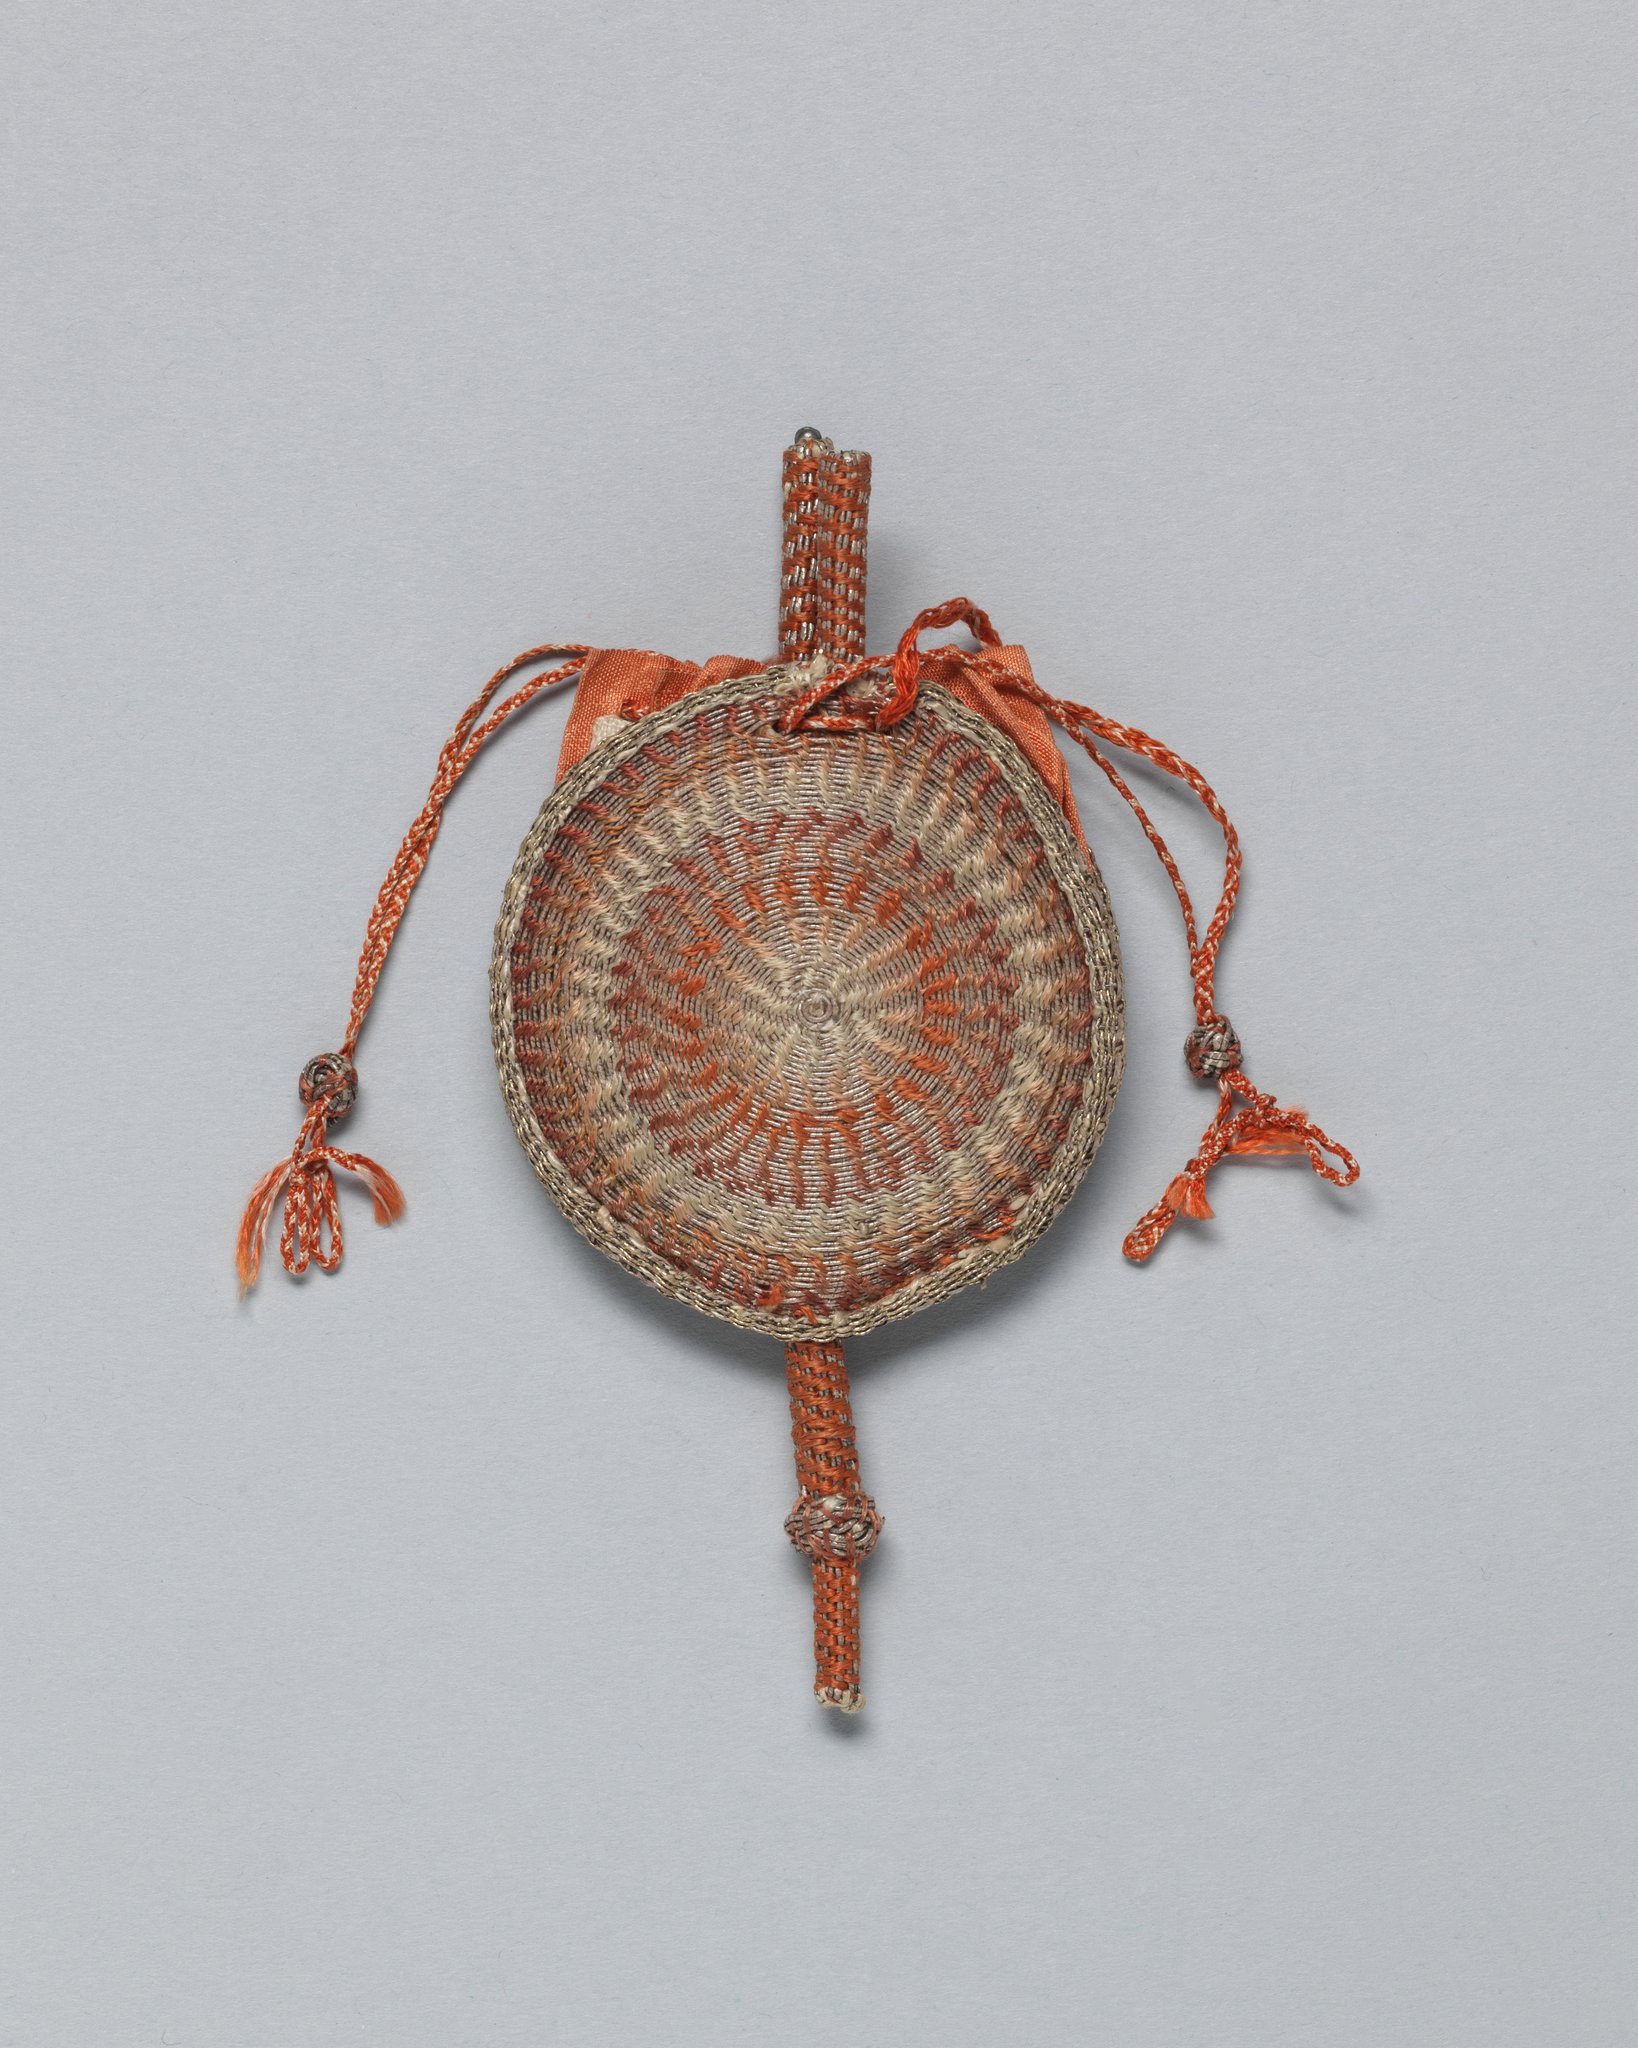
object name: perfume sprinkler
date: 1651-1675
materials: metal thread, silk